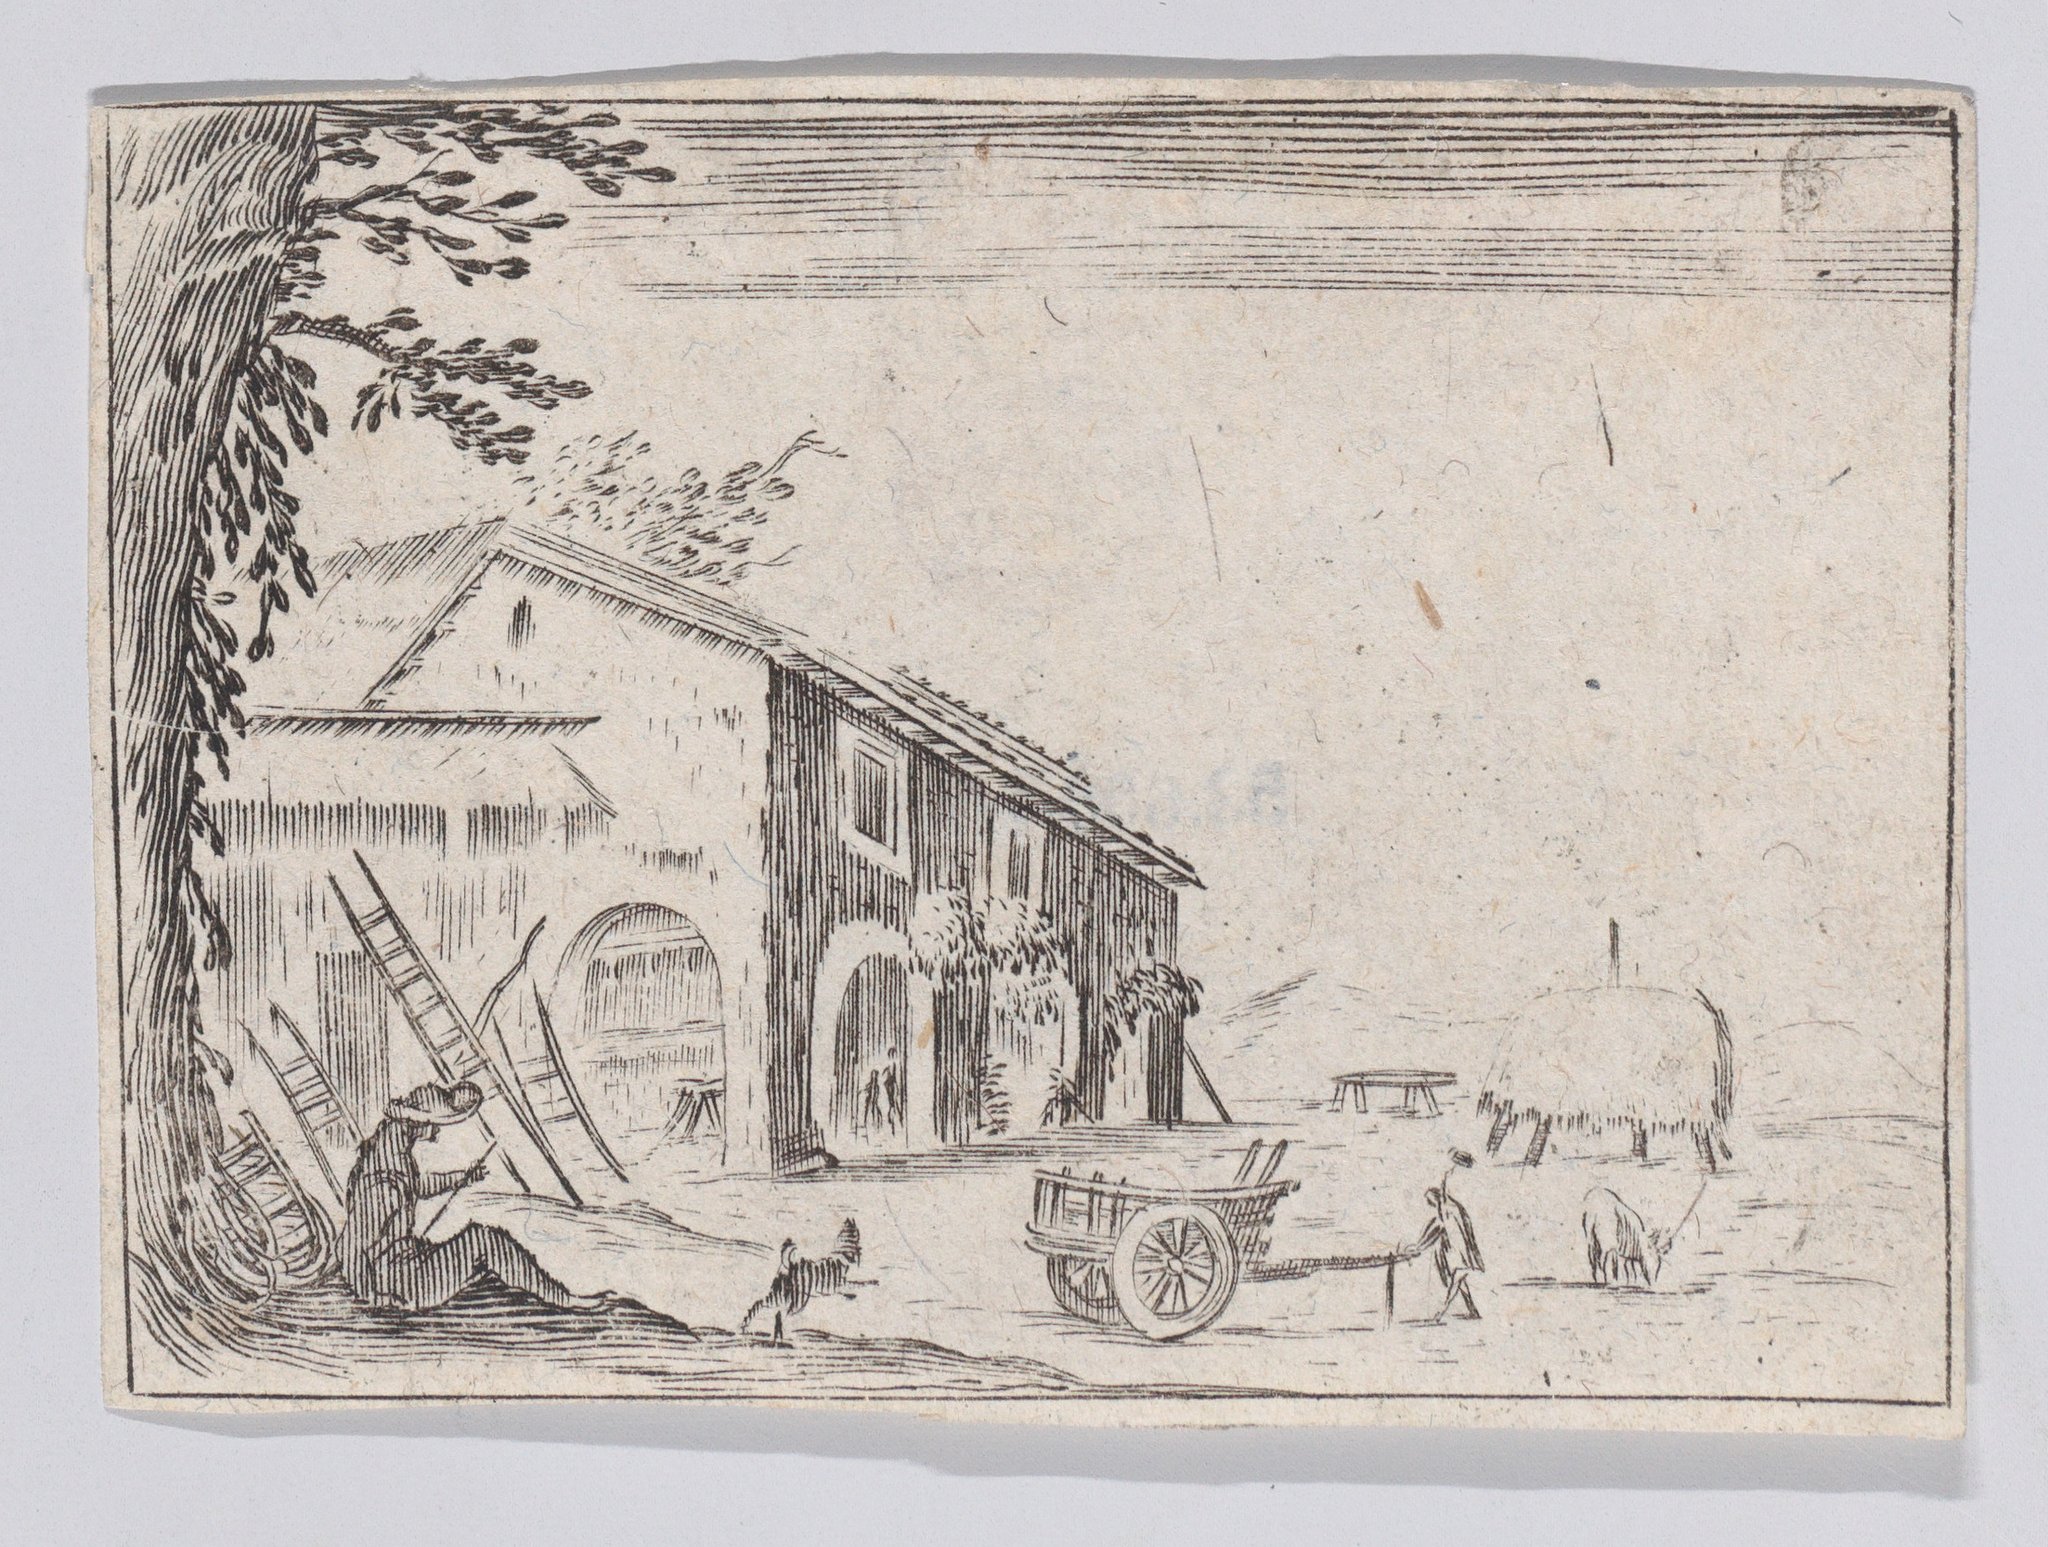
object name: print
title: Reverse Copy of La Factoria (The Factory), from Les Caprices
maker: Anonymous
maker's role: artist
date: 1601-1700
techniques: etching